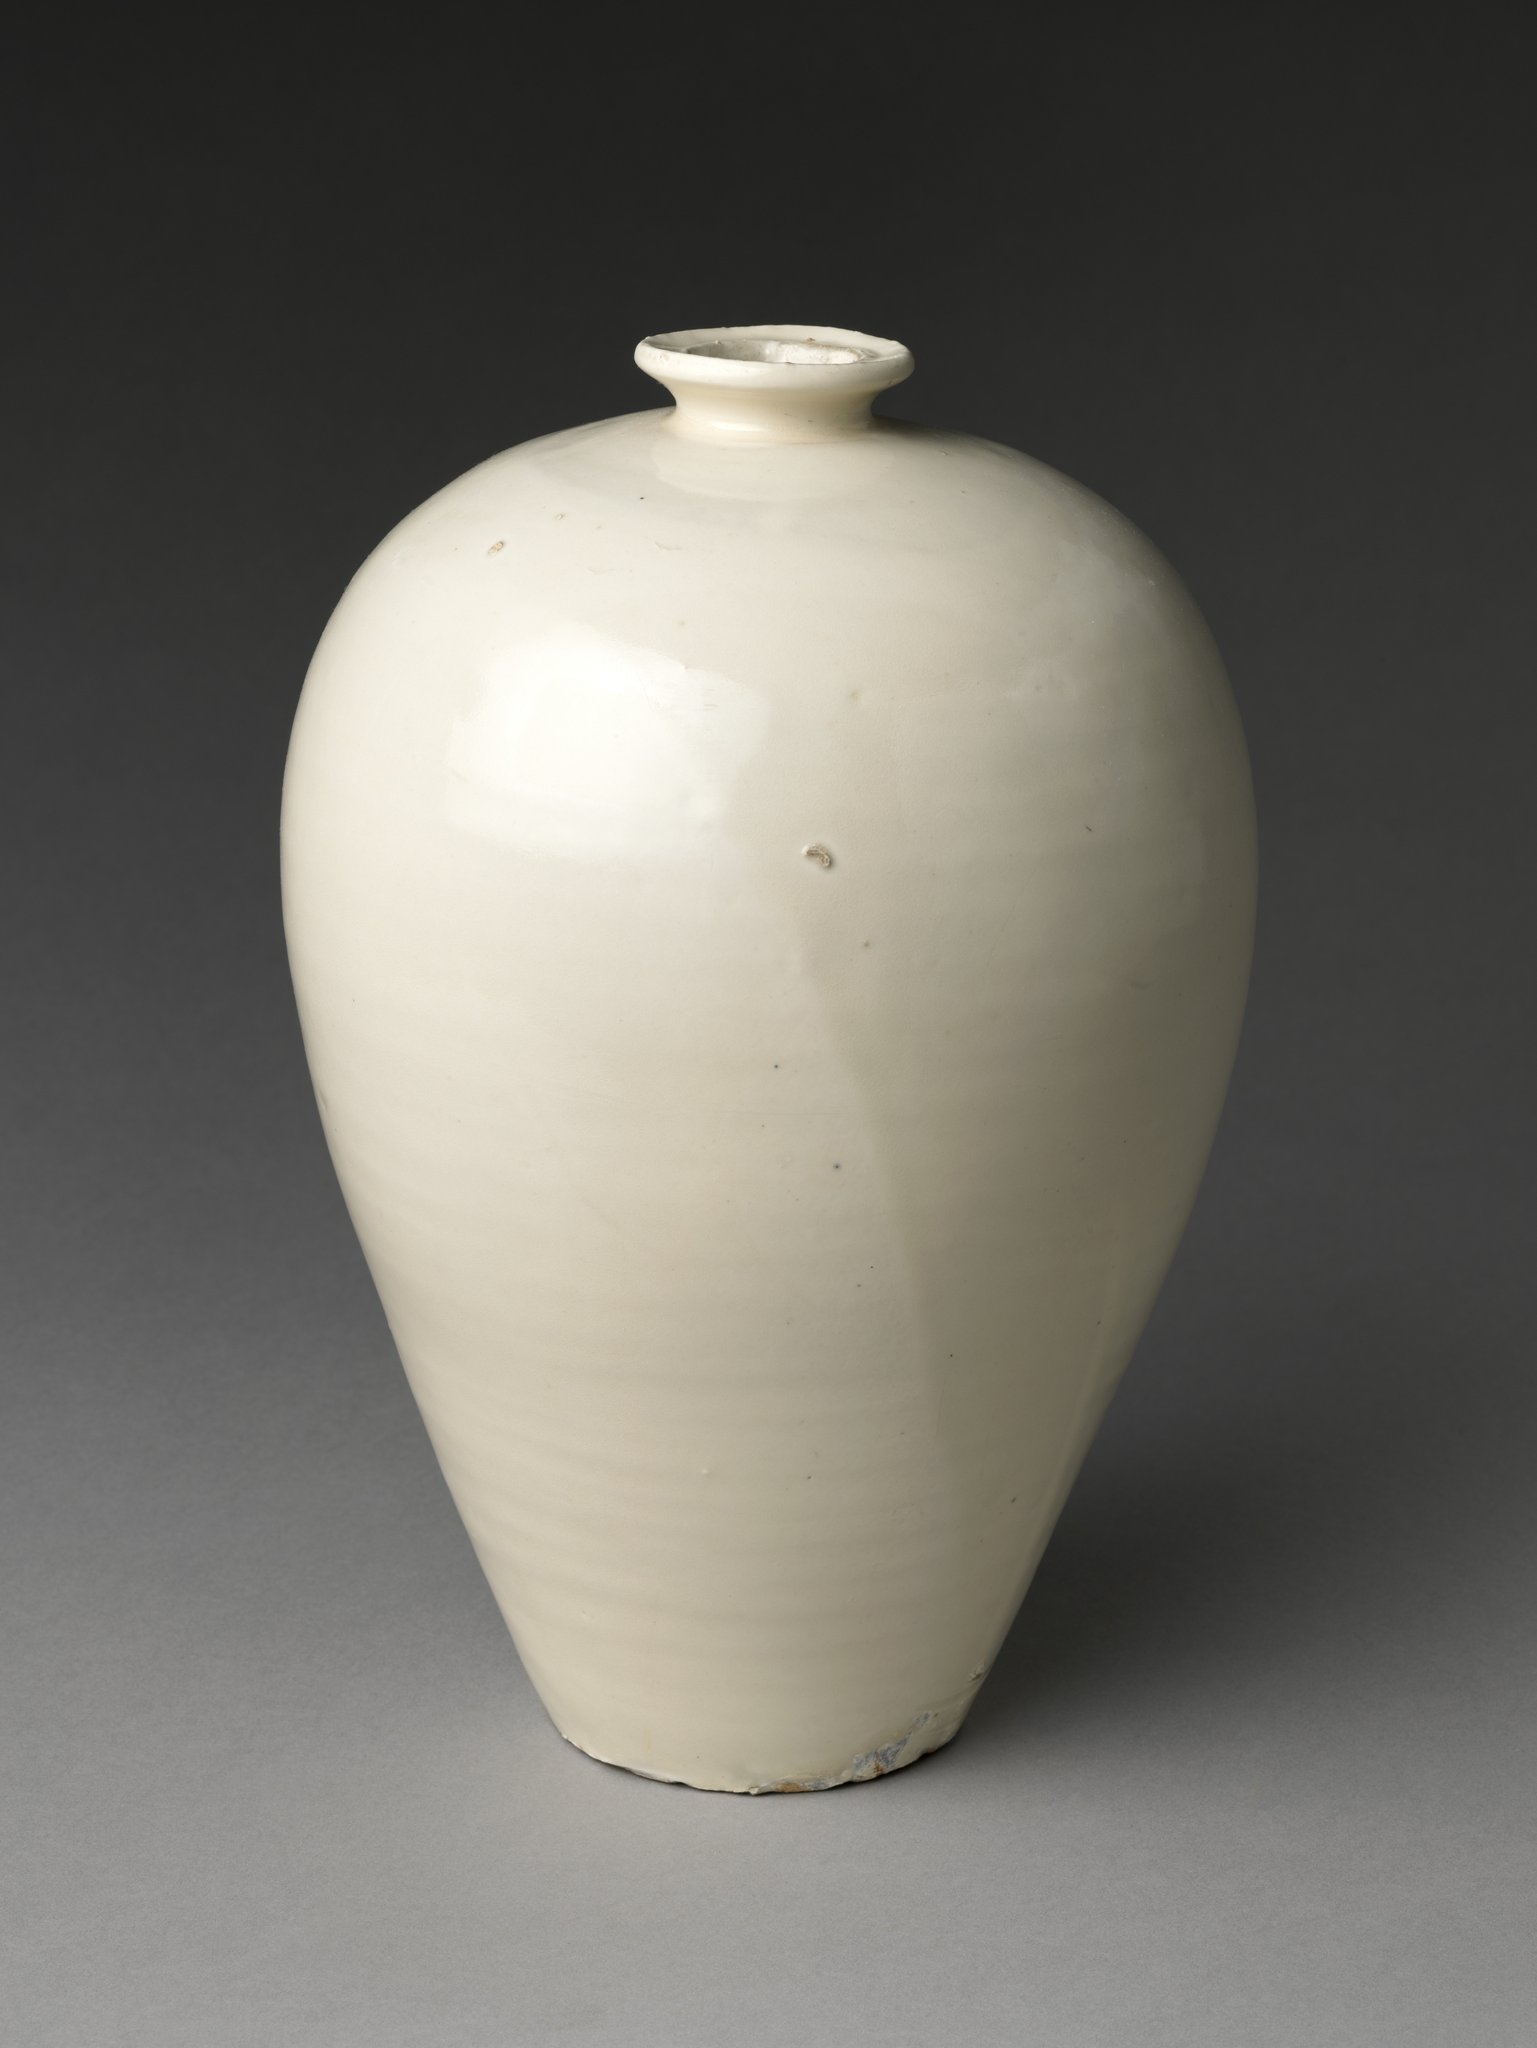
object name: vase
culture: chinese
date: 1001-1200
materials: glaze, stoneware